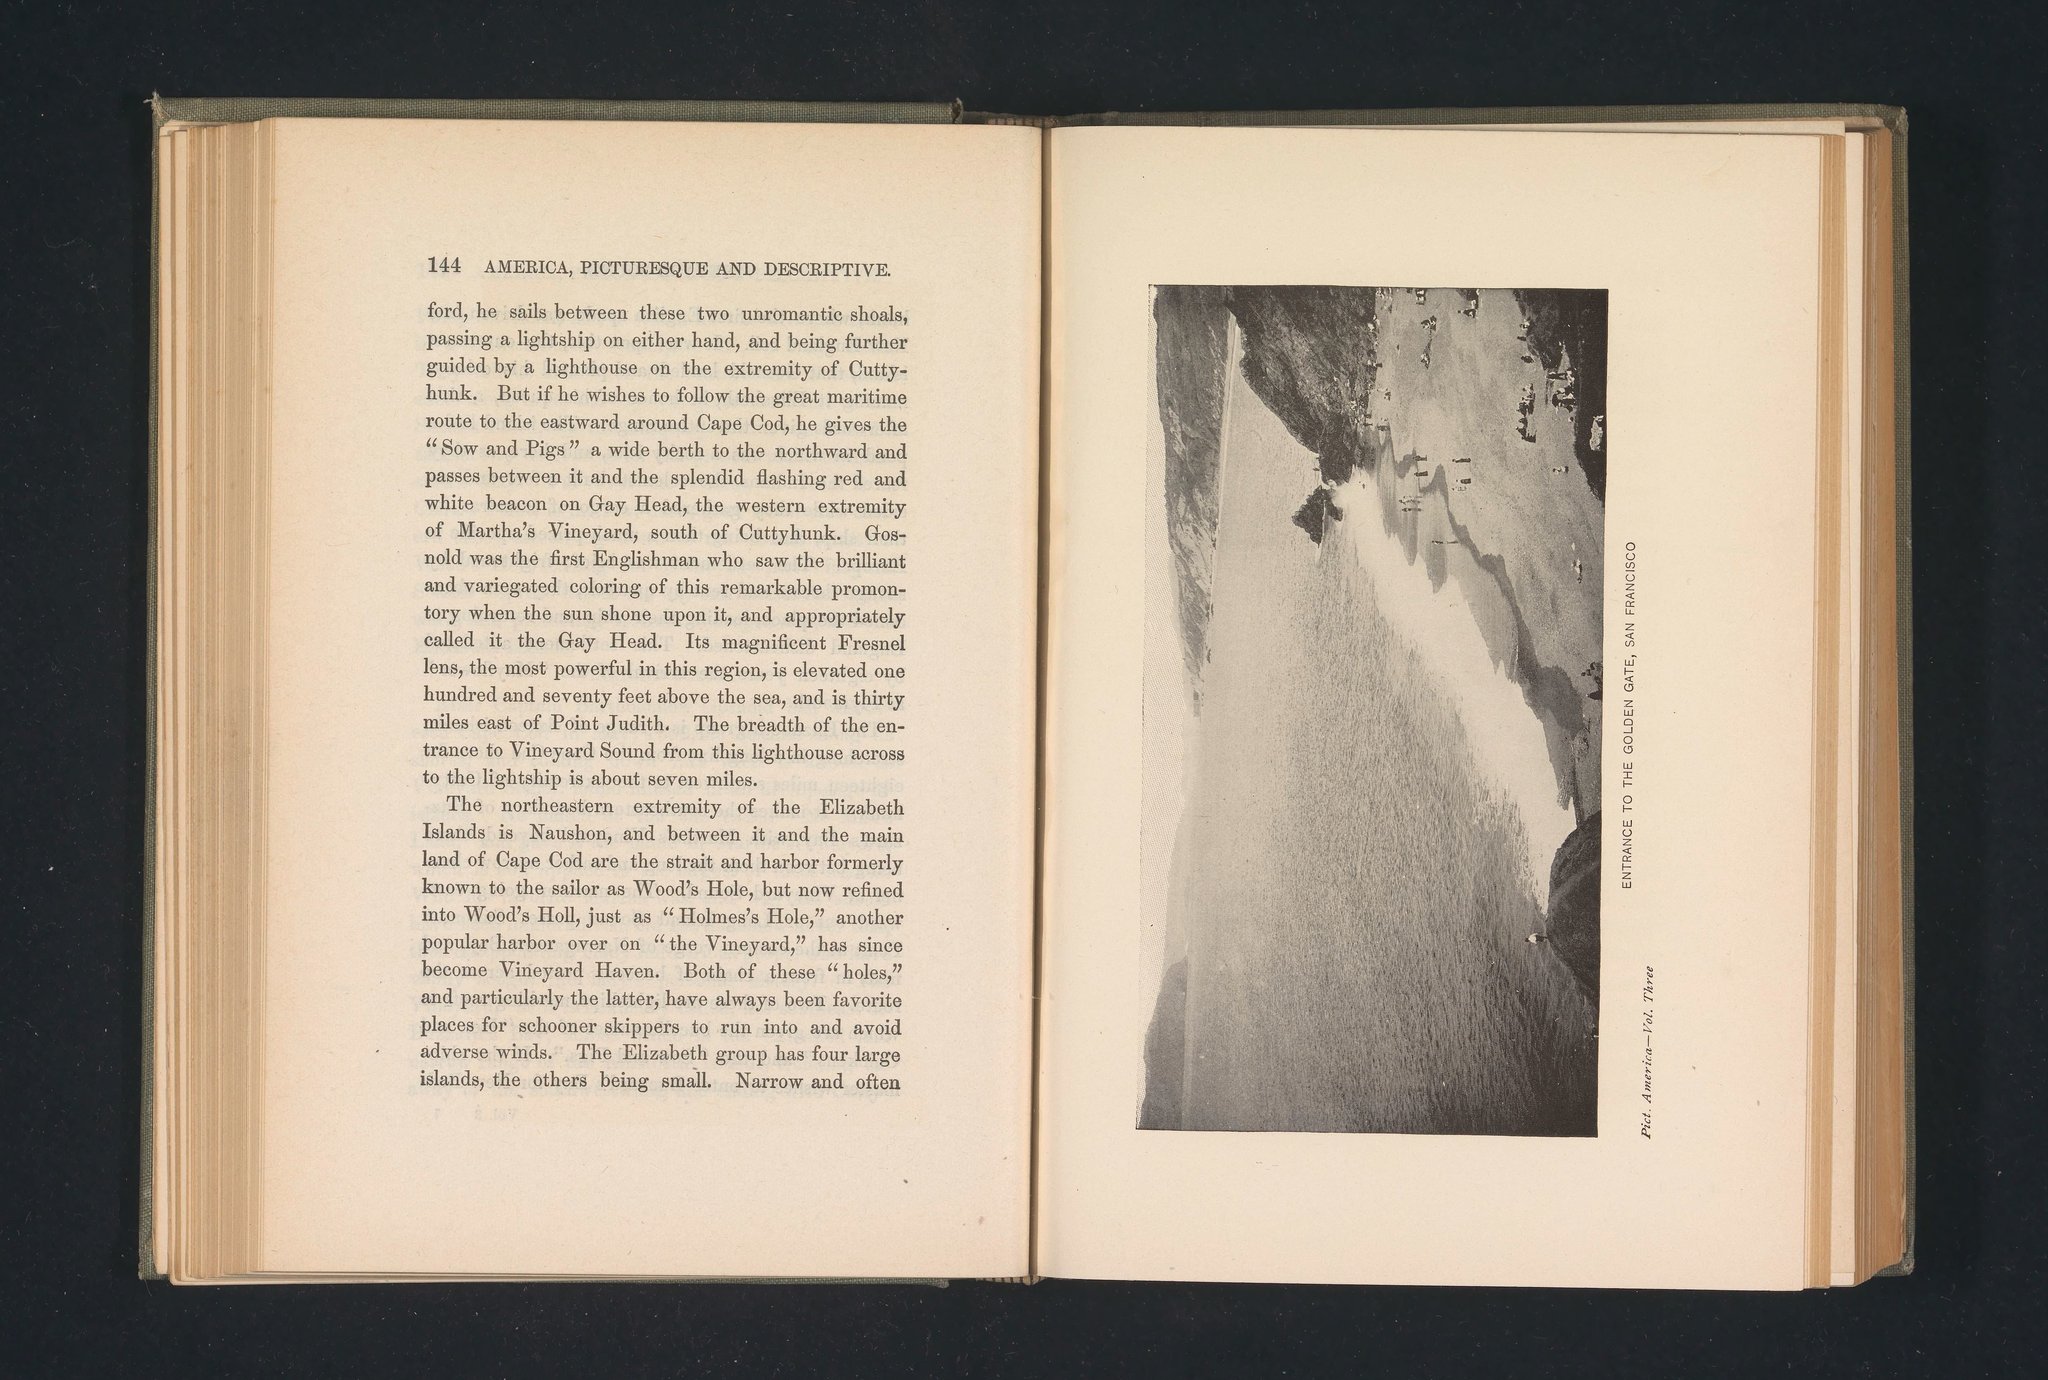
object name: photomechanical print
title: Entrance to the Golden Gate, San Francisco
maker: Anonymous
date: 1890-1900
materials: paper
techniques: autotype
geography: california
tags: gulf, bay, beach